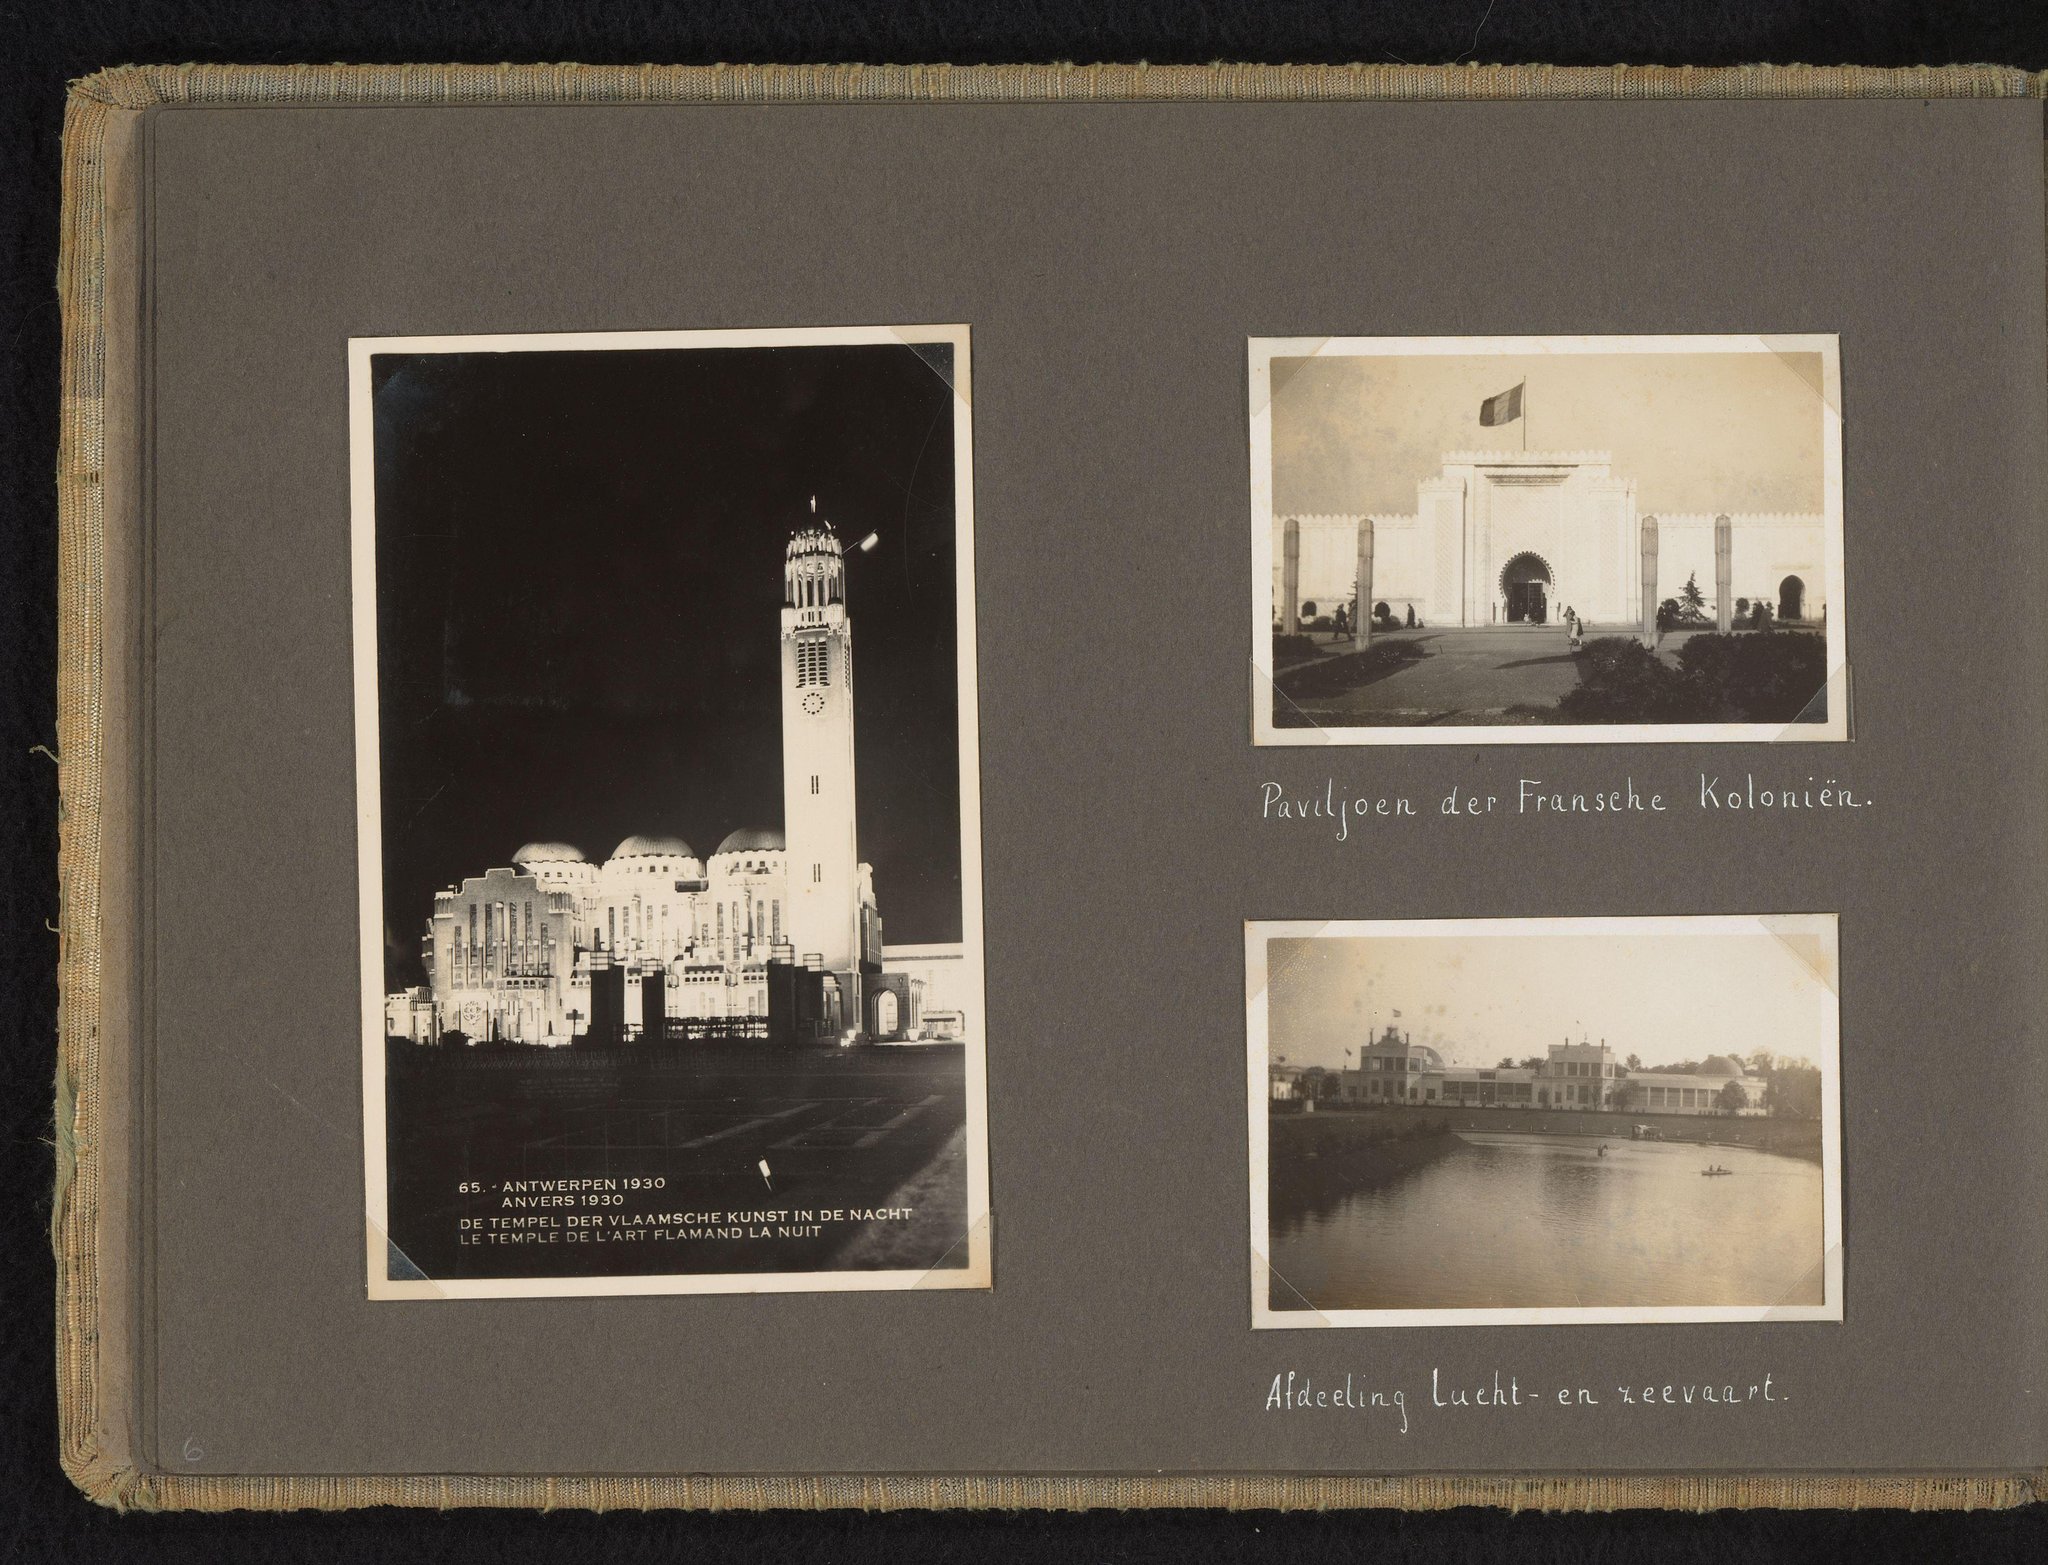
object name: ansichtkaart, prentbriefkaart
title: Bezoek aan de Wereldtentoonstelling te Antwerpen, oktober 1930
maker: Anonymous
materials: cardboard, photographic support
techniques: gelatin silver print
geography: antwerp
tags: world fair, world exhibition, outing, pleasure trip, student life, antwerp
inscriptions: inscription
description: Albumblad met twee foto's en een prentbriefkaart van een bezoek aan verschillende paviljoens op de Wereldtentoonstelling te Antwerpen in 1930. Onderdeel van fotoalbum 'Studentenalbum Indologen'.